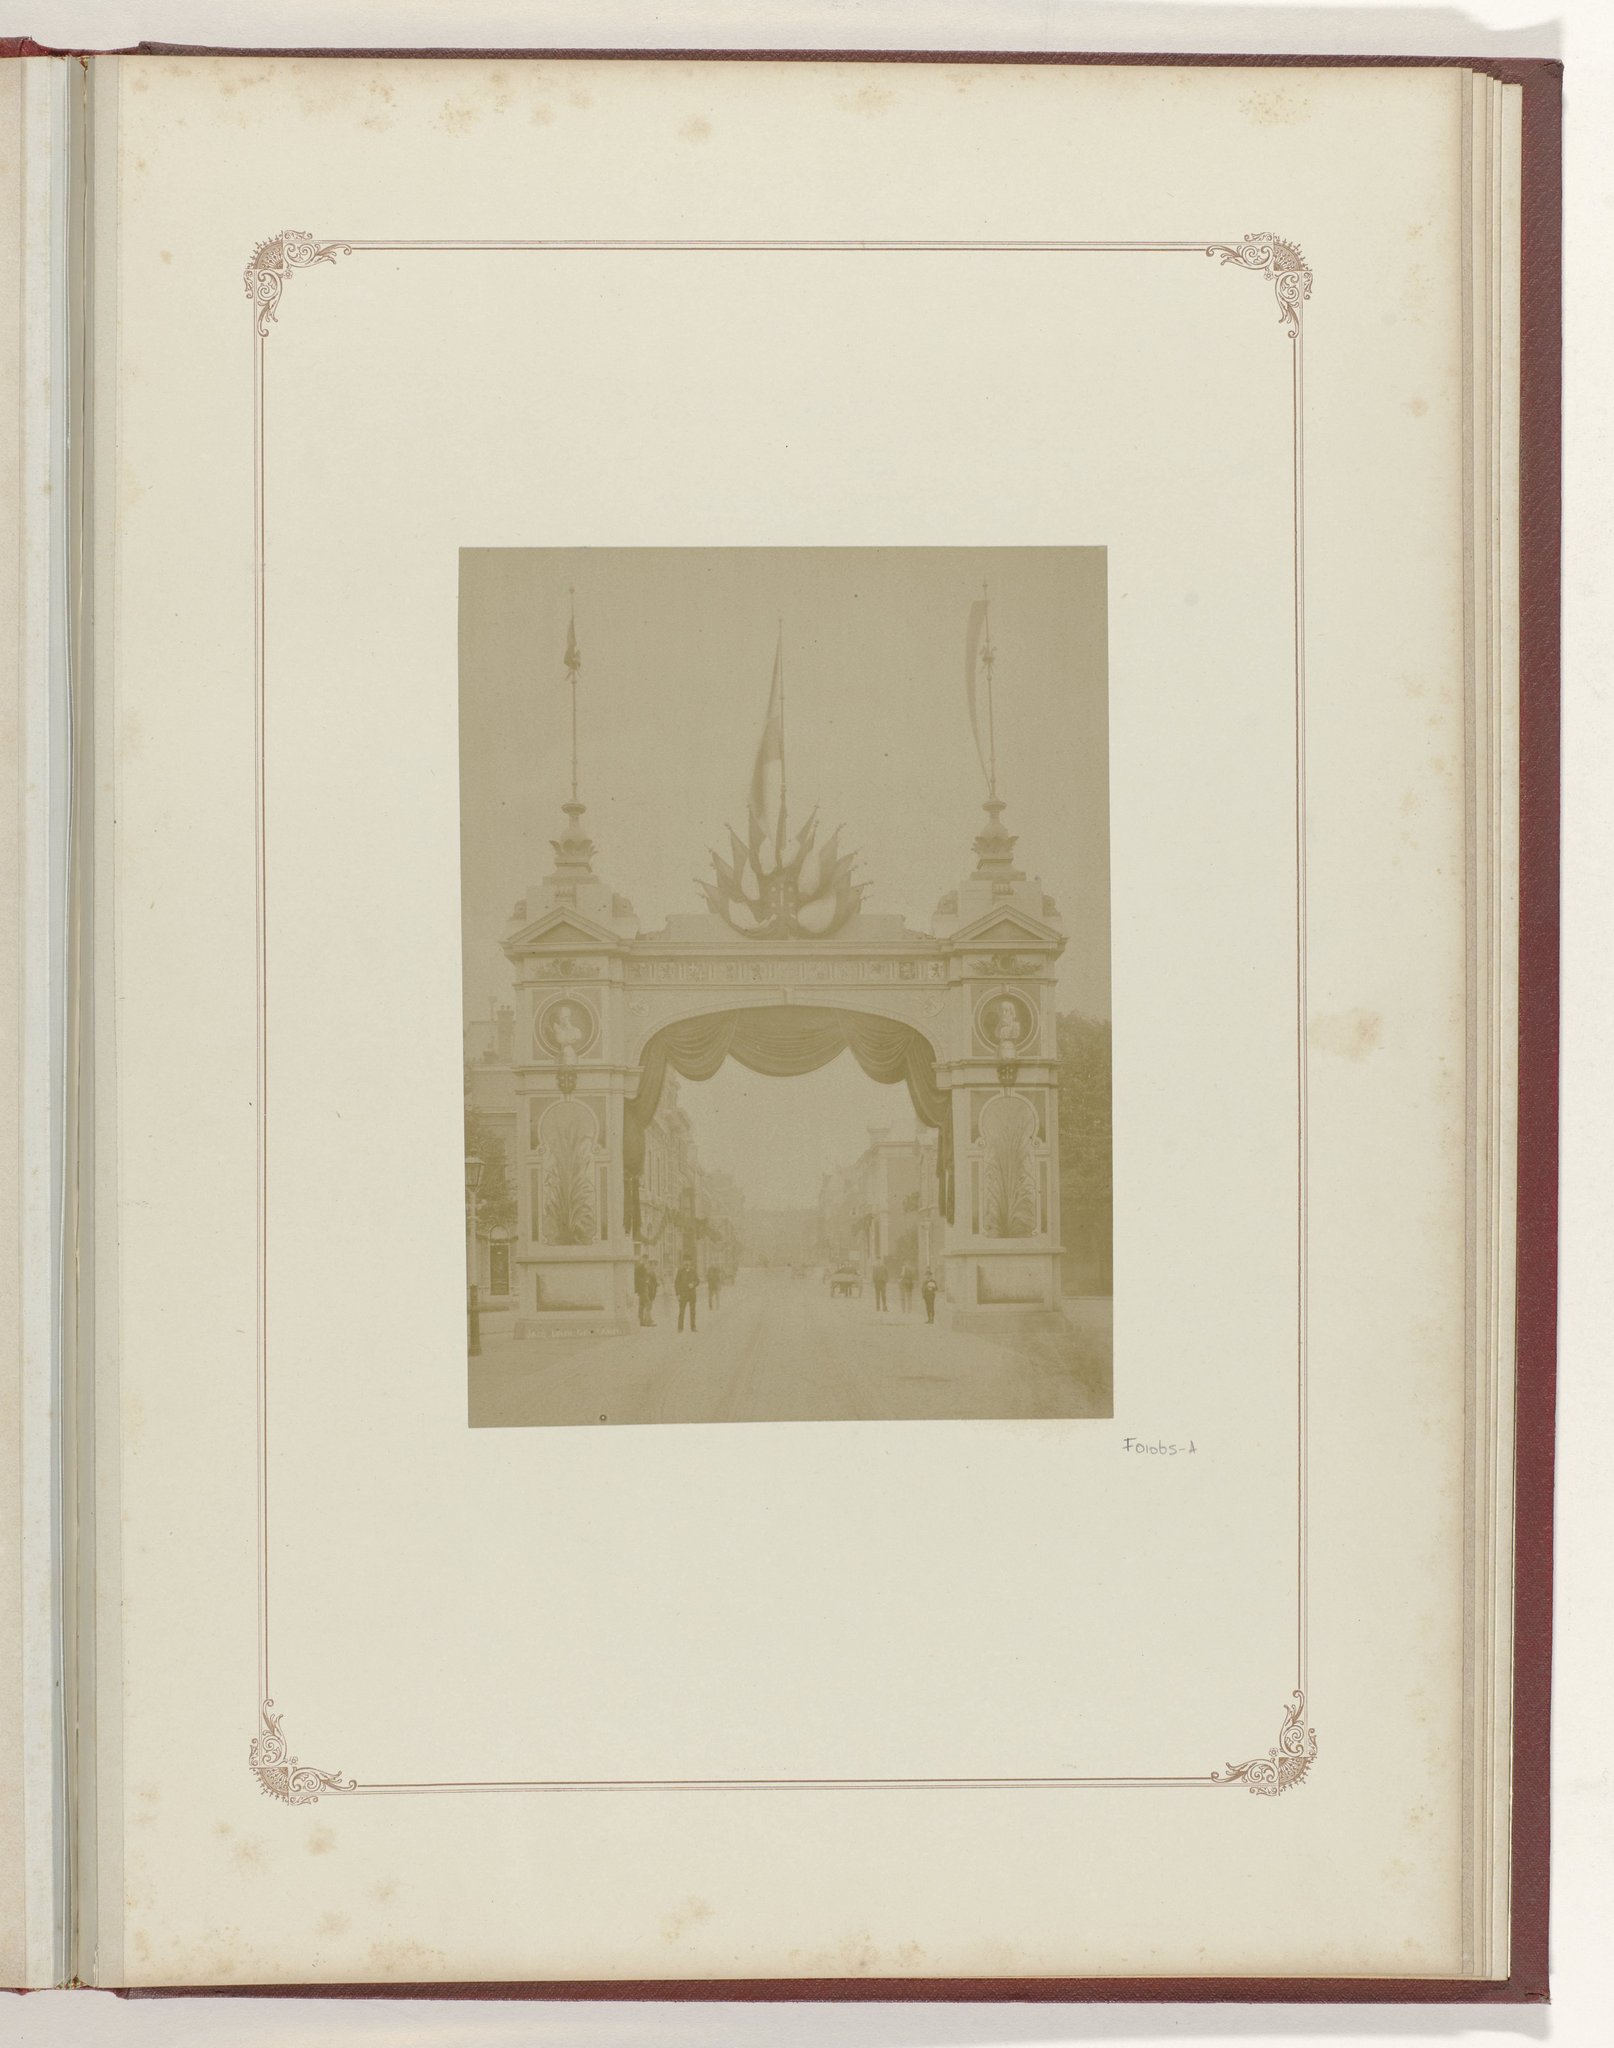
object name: photograph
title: Eereboog op den Kruisweg bij de Parklaan/ ontworpen door Jacques Leijh, Gemeente-Architect van haarlem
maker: Anonymous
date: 1892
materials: cardboard, photographic support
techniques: albumen print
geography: haarlem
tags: triumphal arch, public festivities, street, city-gate, haarlem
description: Ereboog ter gelegenheid van het bezoek van koningin-regentes Emma aan Haarlem op 23 september 1892. Deze foto maakt deel uit van een album.